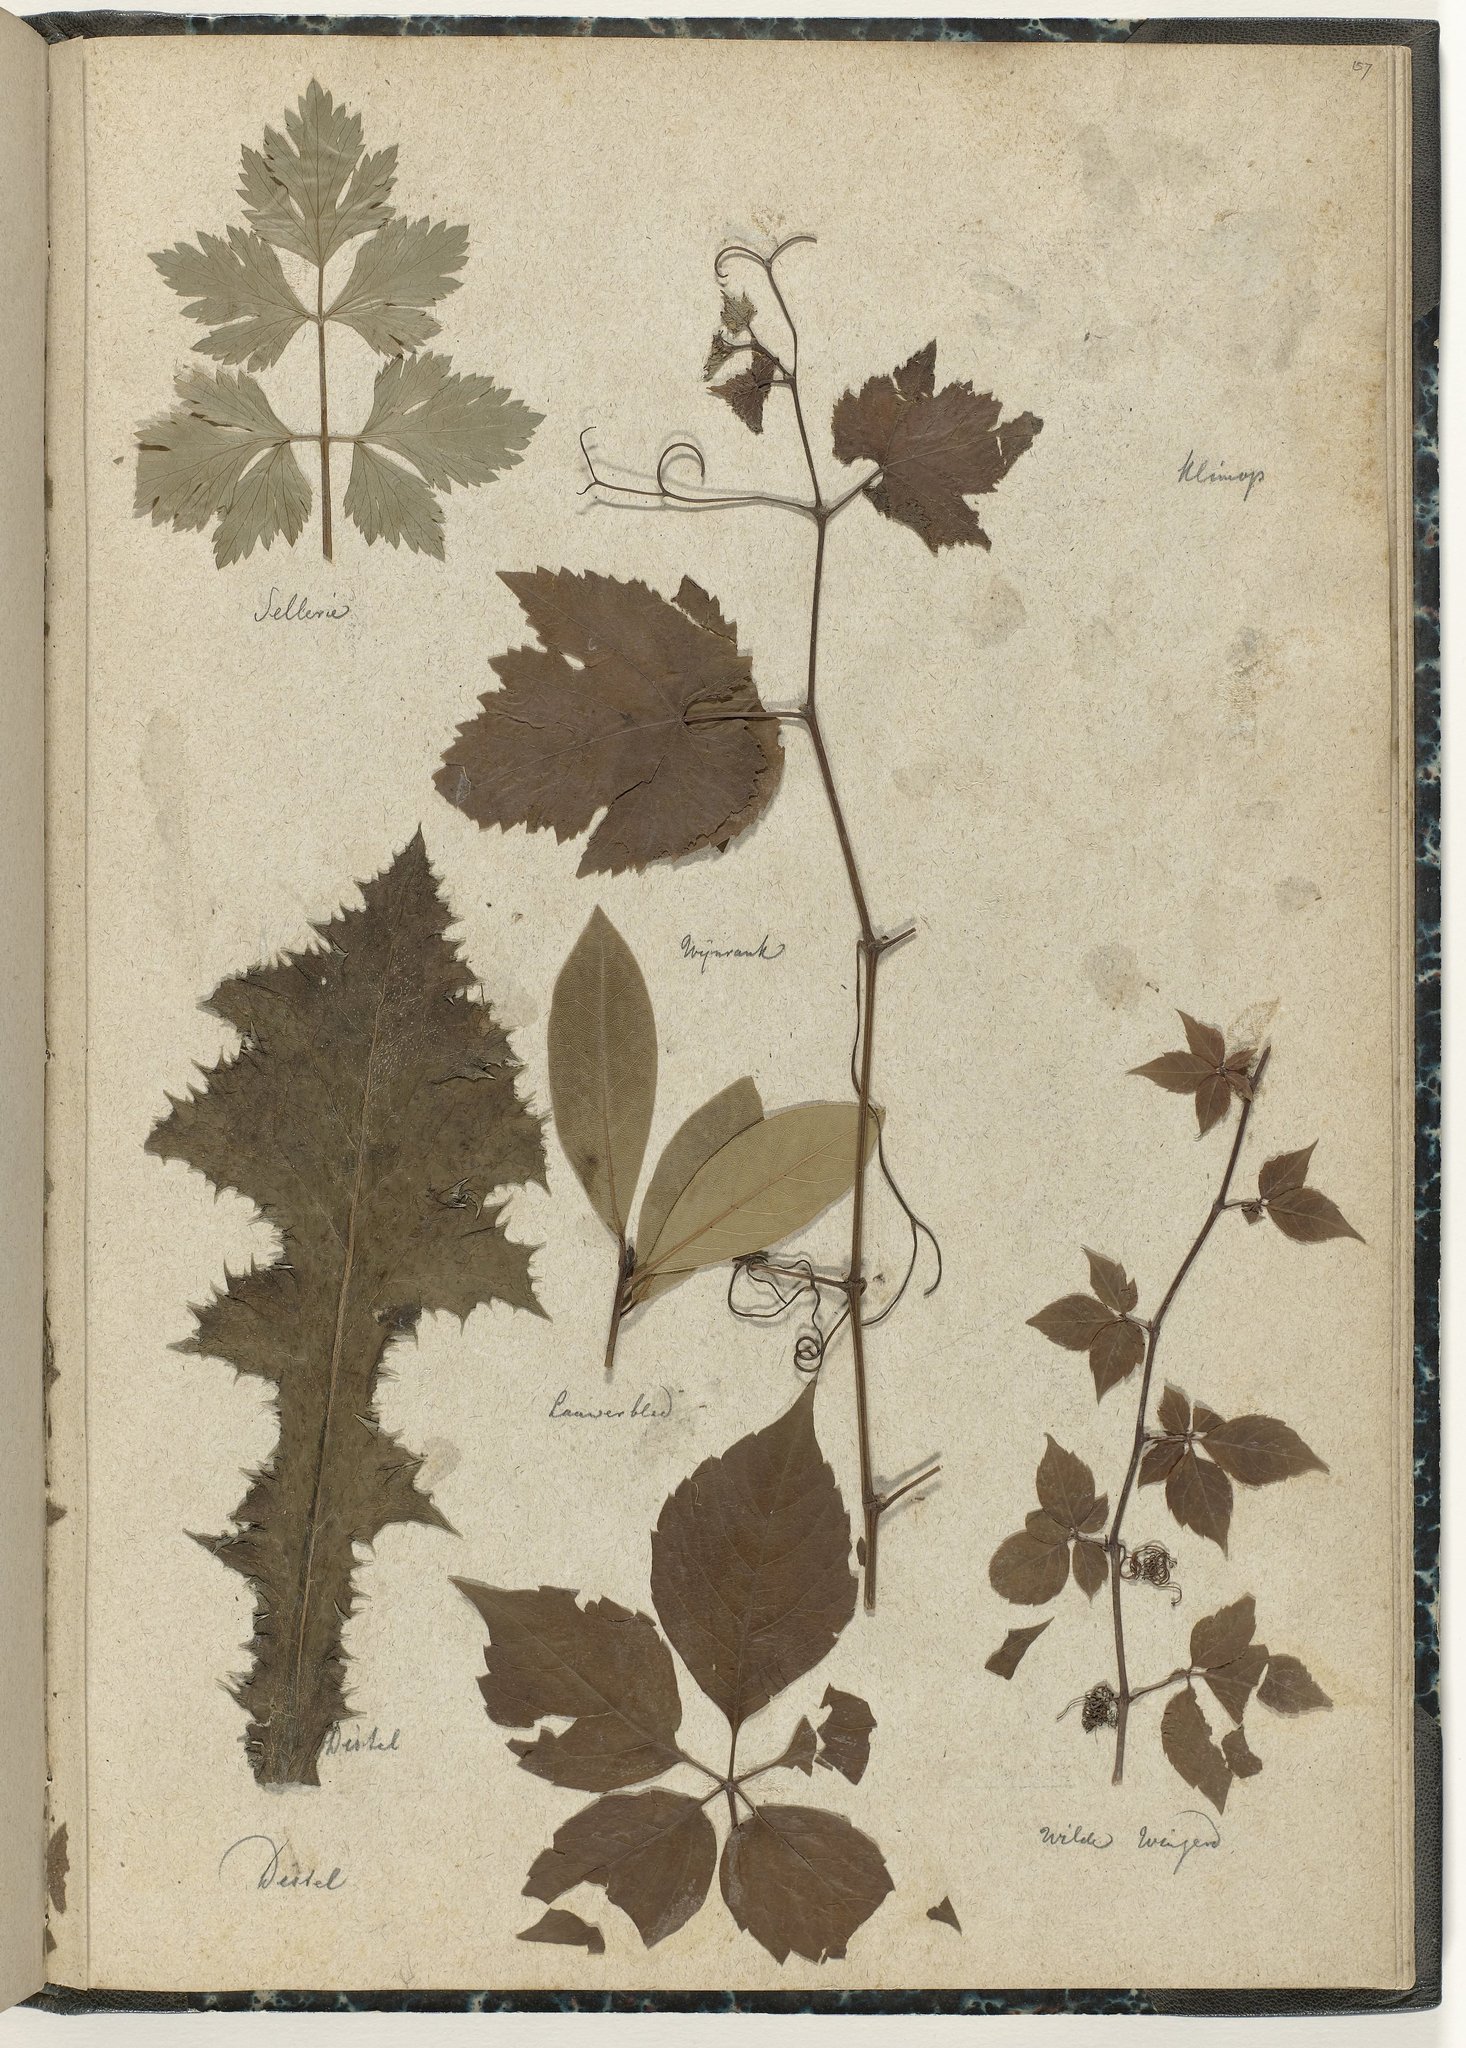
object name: collage visual work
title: Bladeren van verschillende planten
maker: p.j. kool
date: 1866-1900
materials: leaf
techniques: printmaking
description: Opgeplakte bladeren afkomstig van selderie, distel, laurier, wijnstok en wilde wingerd. Het blad van de klimop rechtsboven is niet meer aanwezig. Onder de bladeren staat met potlood geschreven van welke plant ze afkomstig zijn.